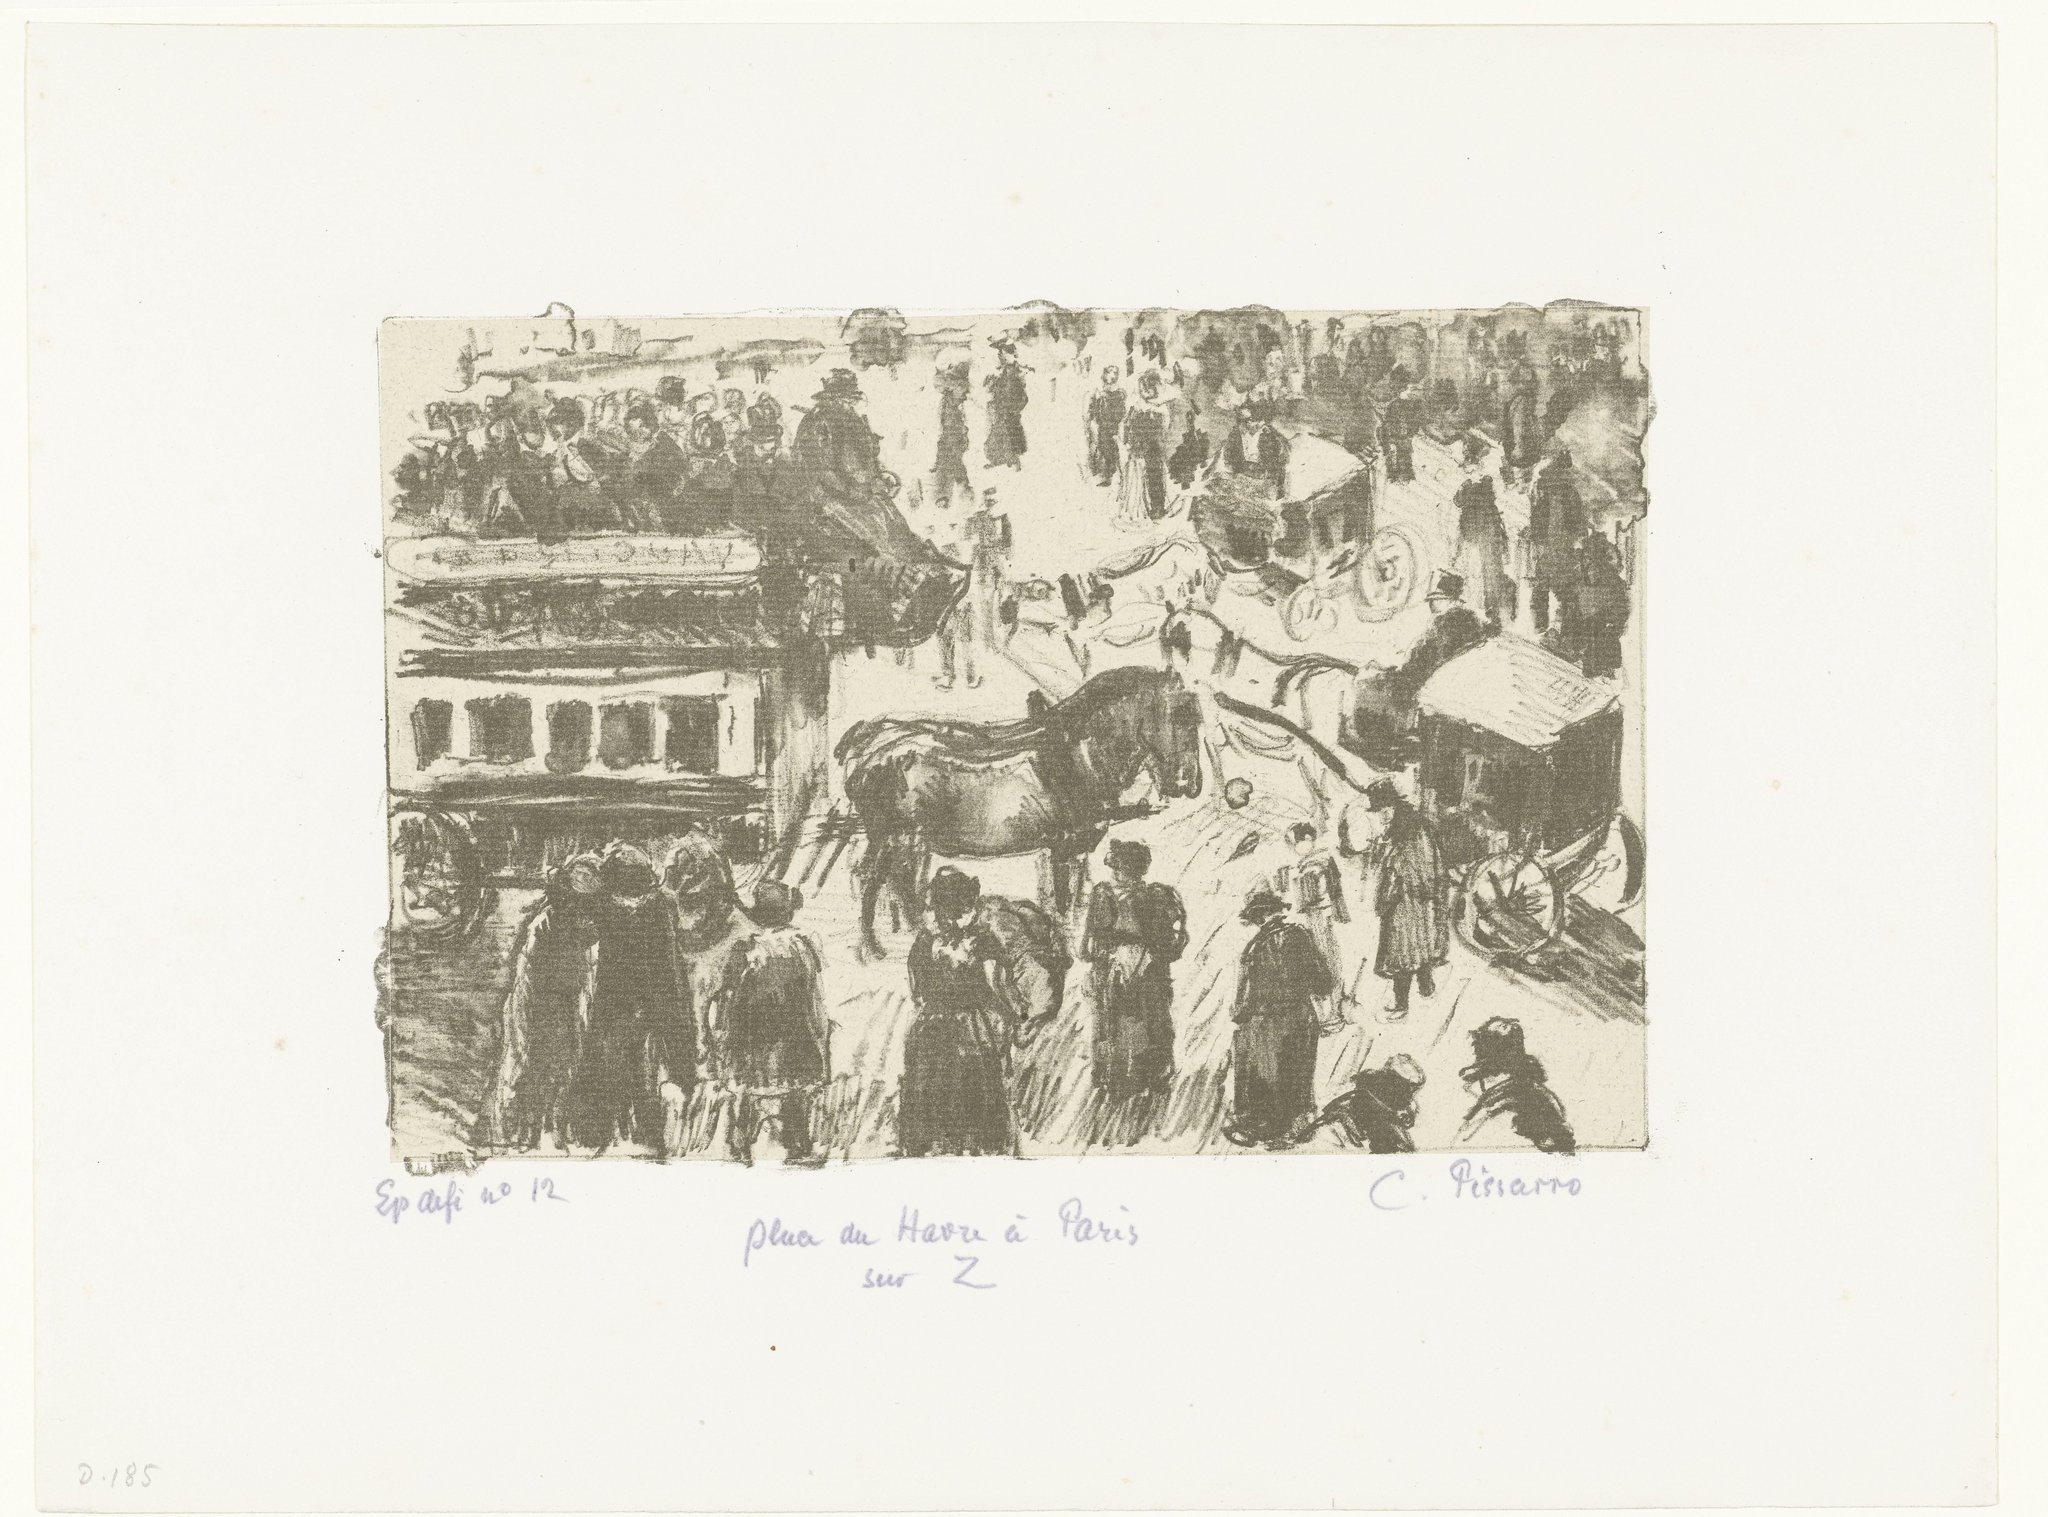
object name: print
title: Place du Havre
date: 1897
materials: paper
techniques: lithograph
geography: paris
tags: square, place, circus, etc., paris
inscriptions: collector's mark: Lugt 2228, inscription: ‘épr. défi no. 12’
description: Het Place du Havre in Parijs. Een druk plein met een aantal koetsen en vele voetgangers.